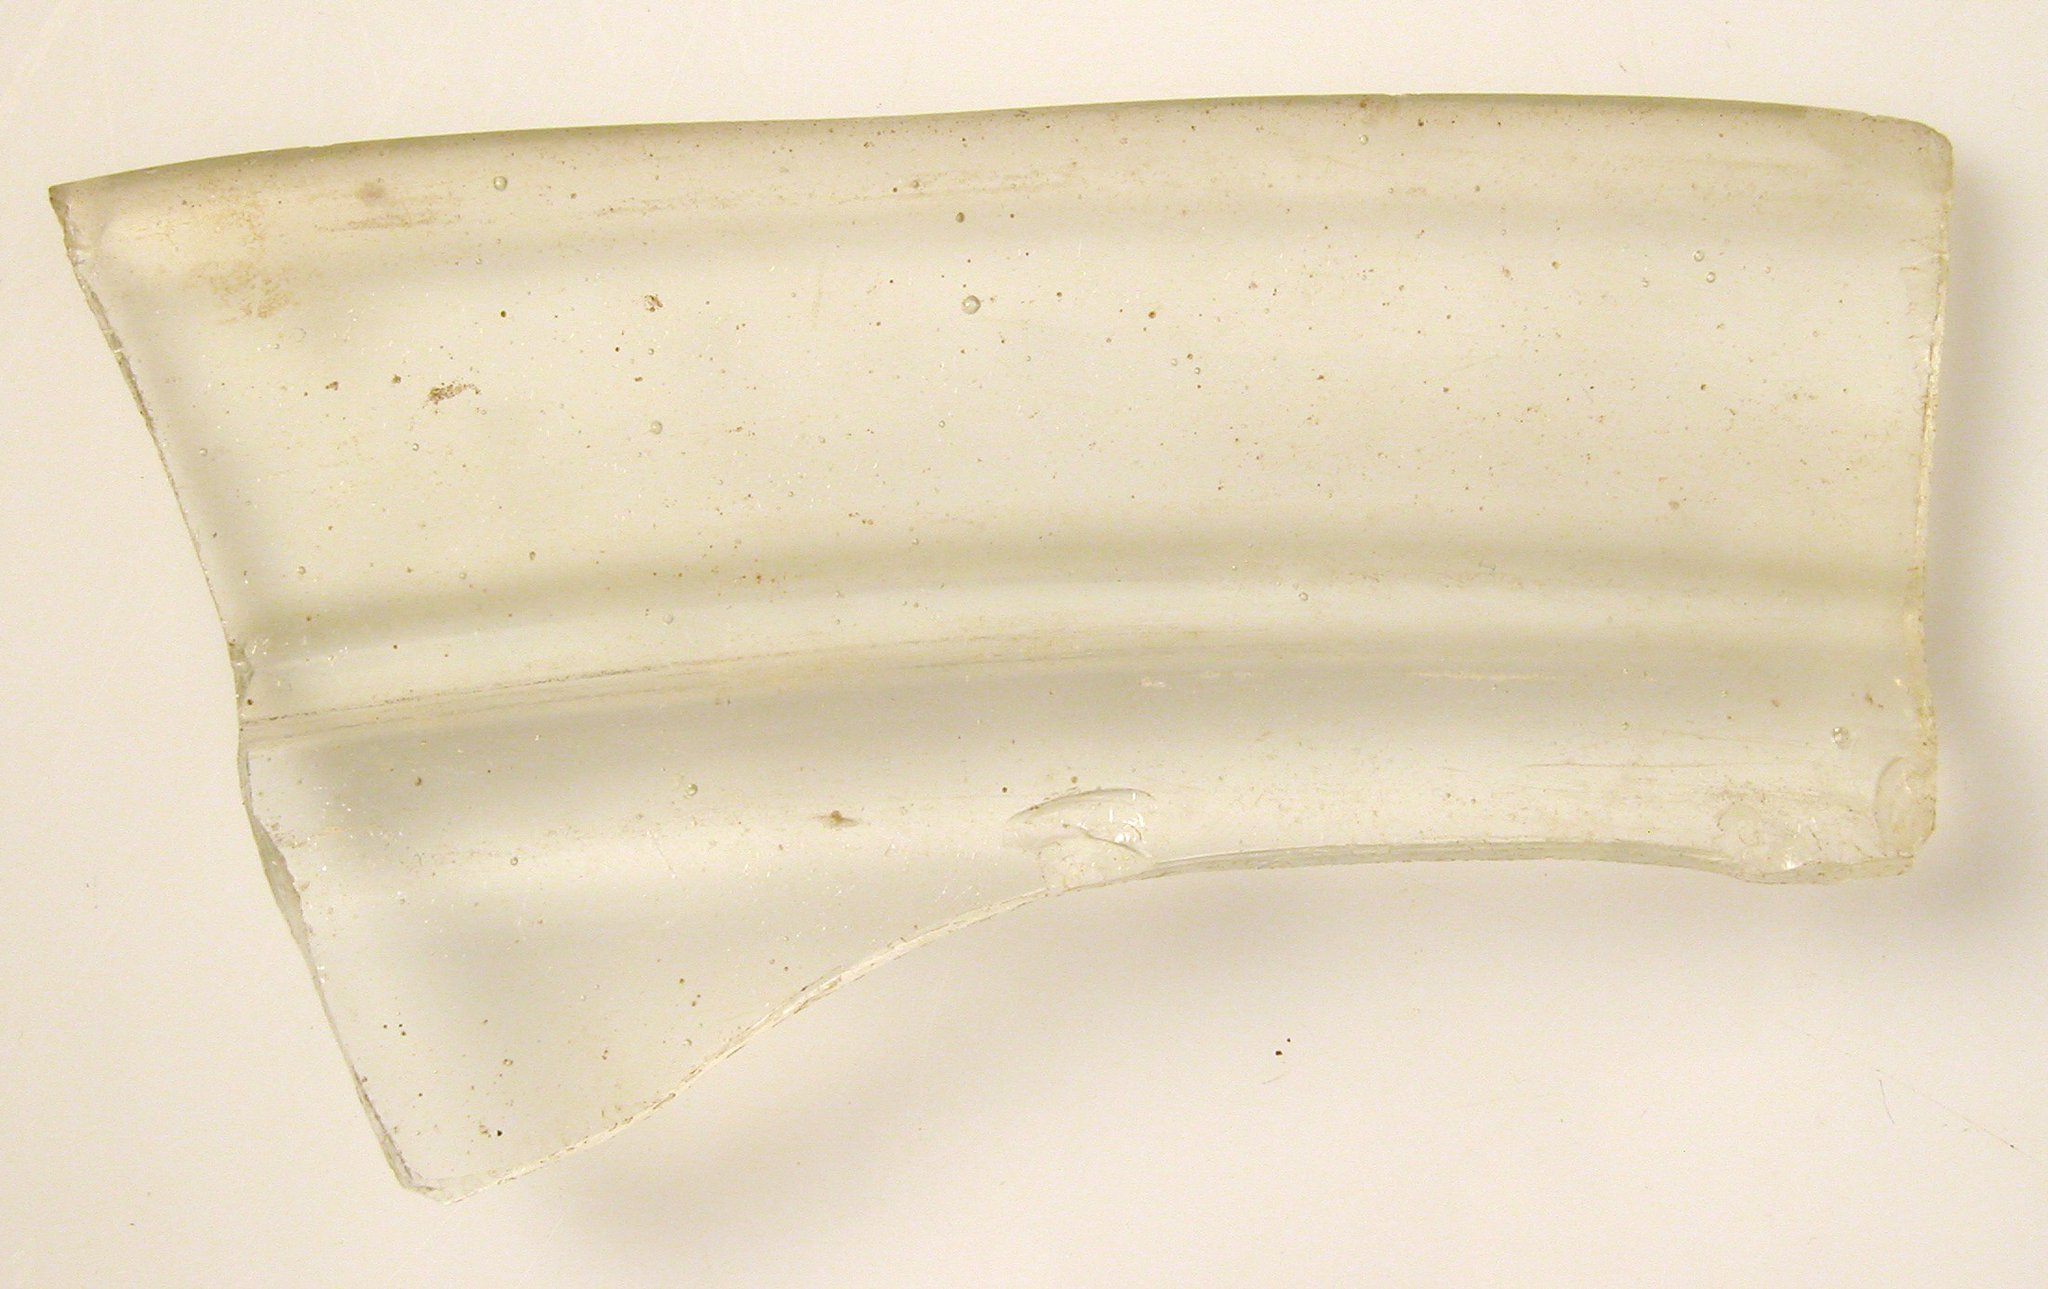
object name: fragment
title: Vessel Fragment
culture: coptic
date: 301-700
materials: glass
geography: egypt